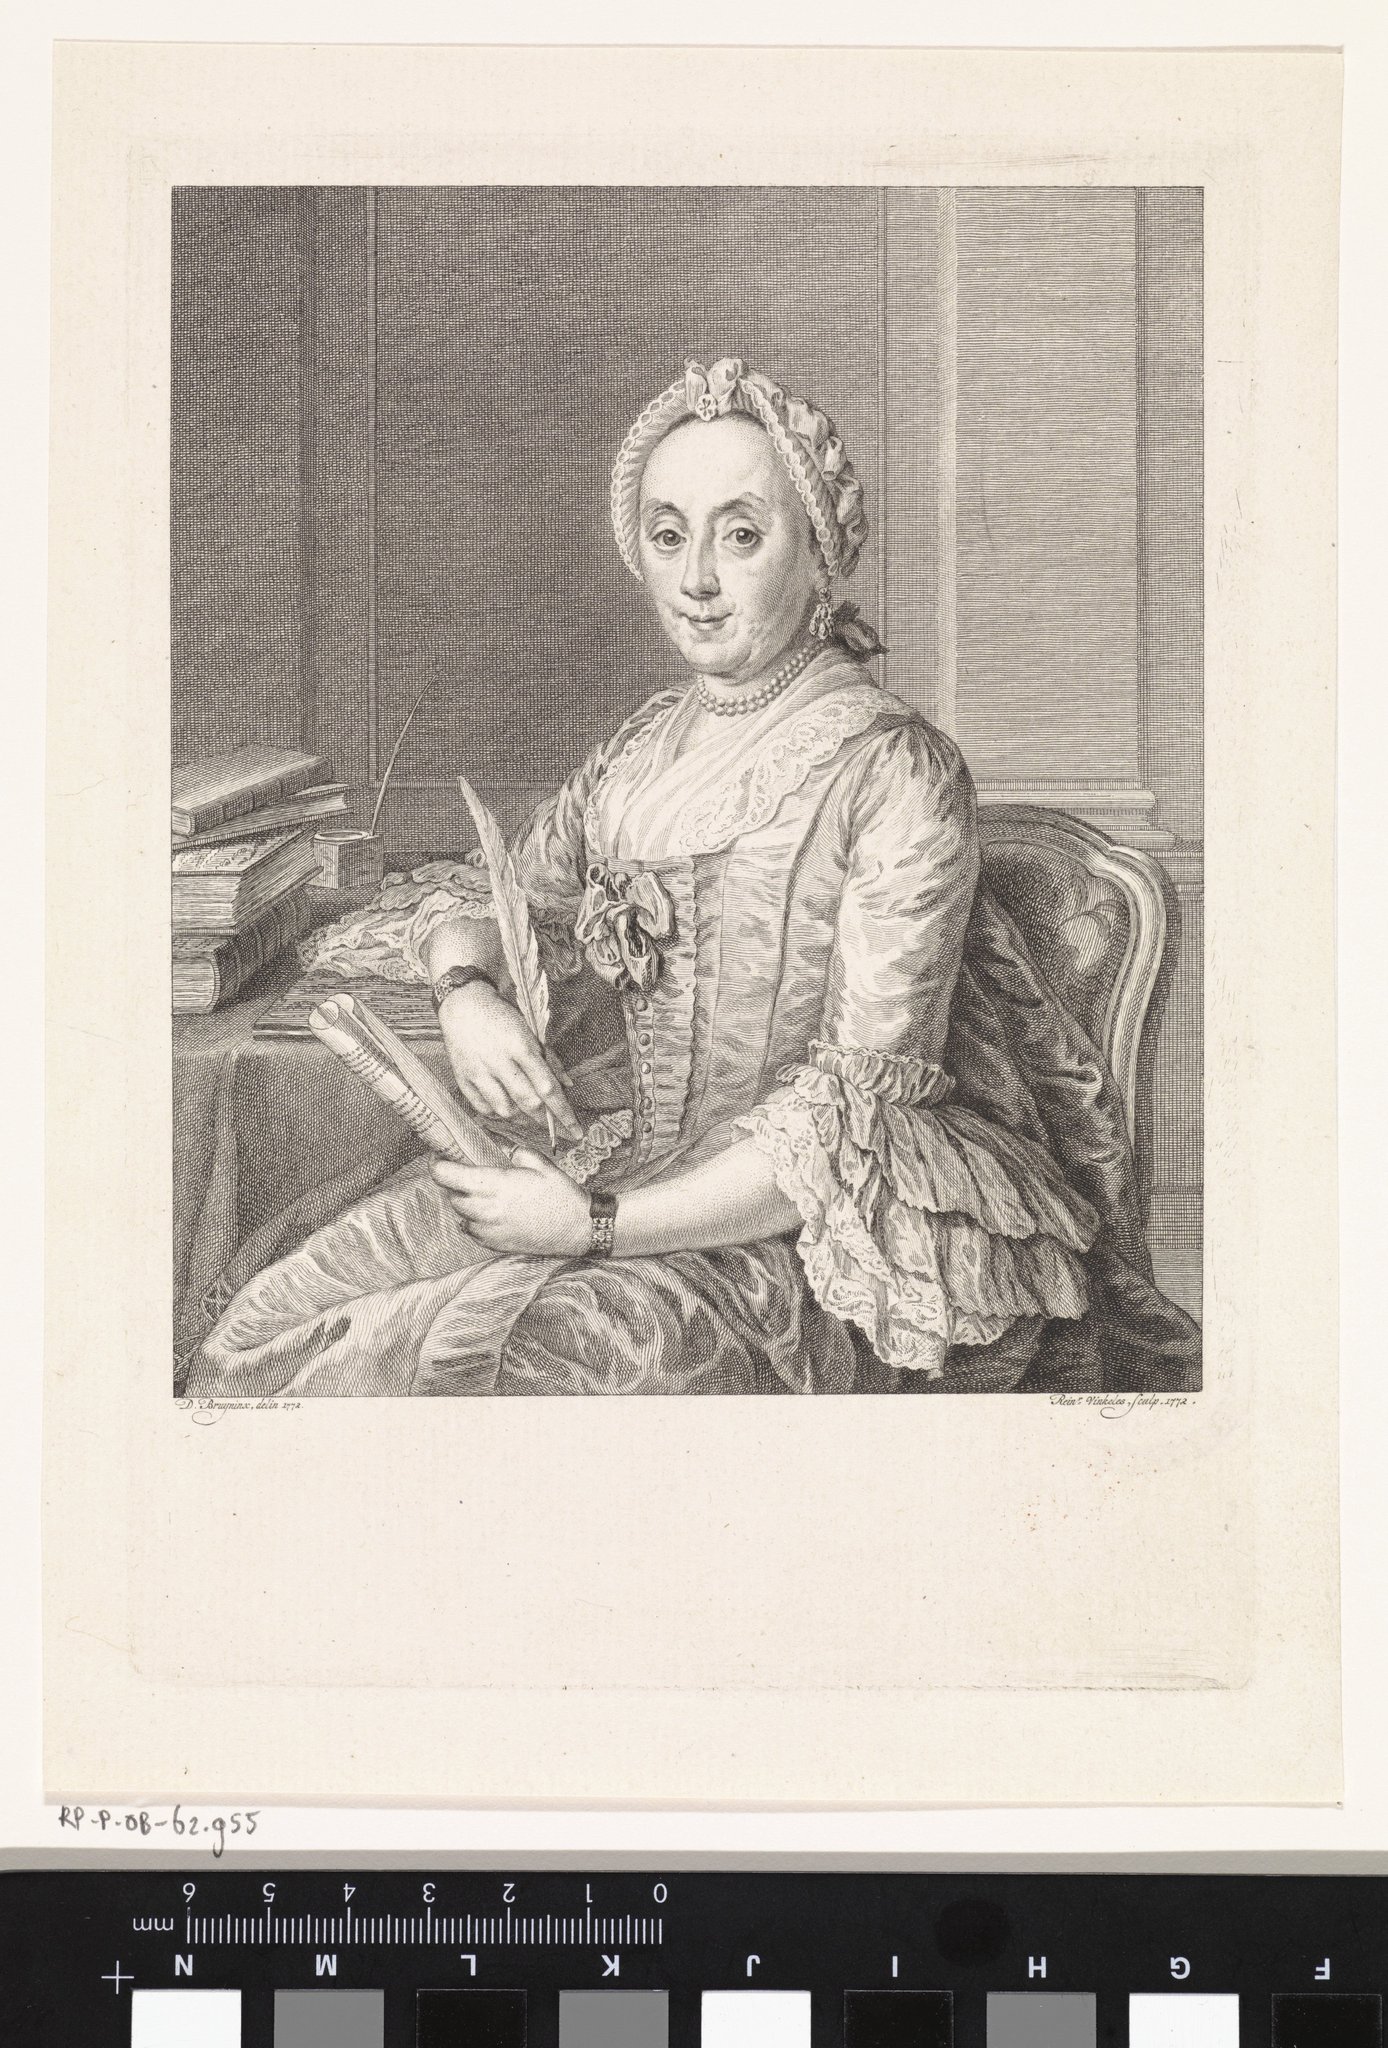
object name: print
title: Portret van Sara Maria van der Wilp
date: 1772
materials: paper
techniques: engraving, etching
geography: amsterdam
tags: amsterdam, sara maria van der wilp, quill, ink-well, paper (writing material)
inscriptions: collector's mark: Lugt 240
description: Portret van de dichteres Sara Maria van der Wilp. Zij zit op een stoel en haar arm leunt op een tafel. In haar handen heeft zij een rol beschreven papier en een schrijfveer. Op tafel staat een inktpot naast een stapel boeken.